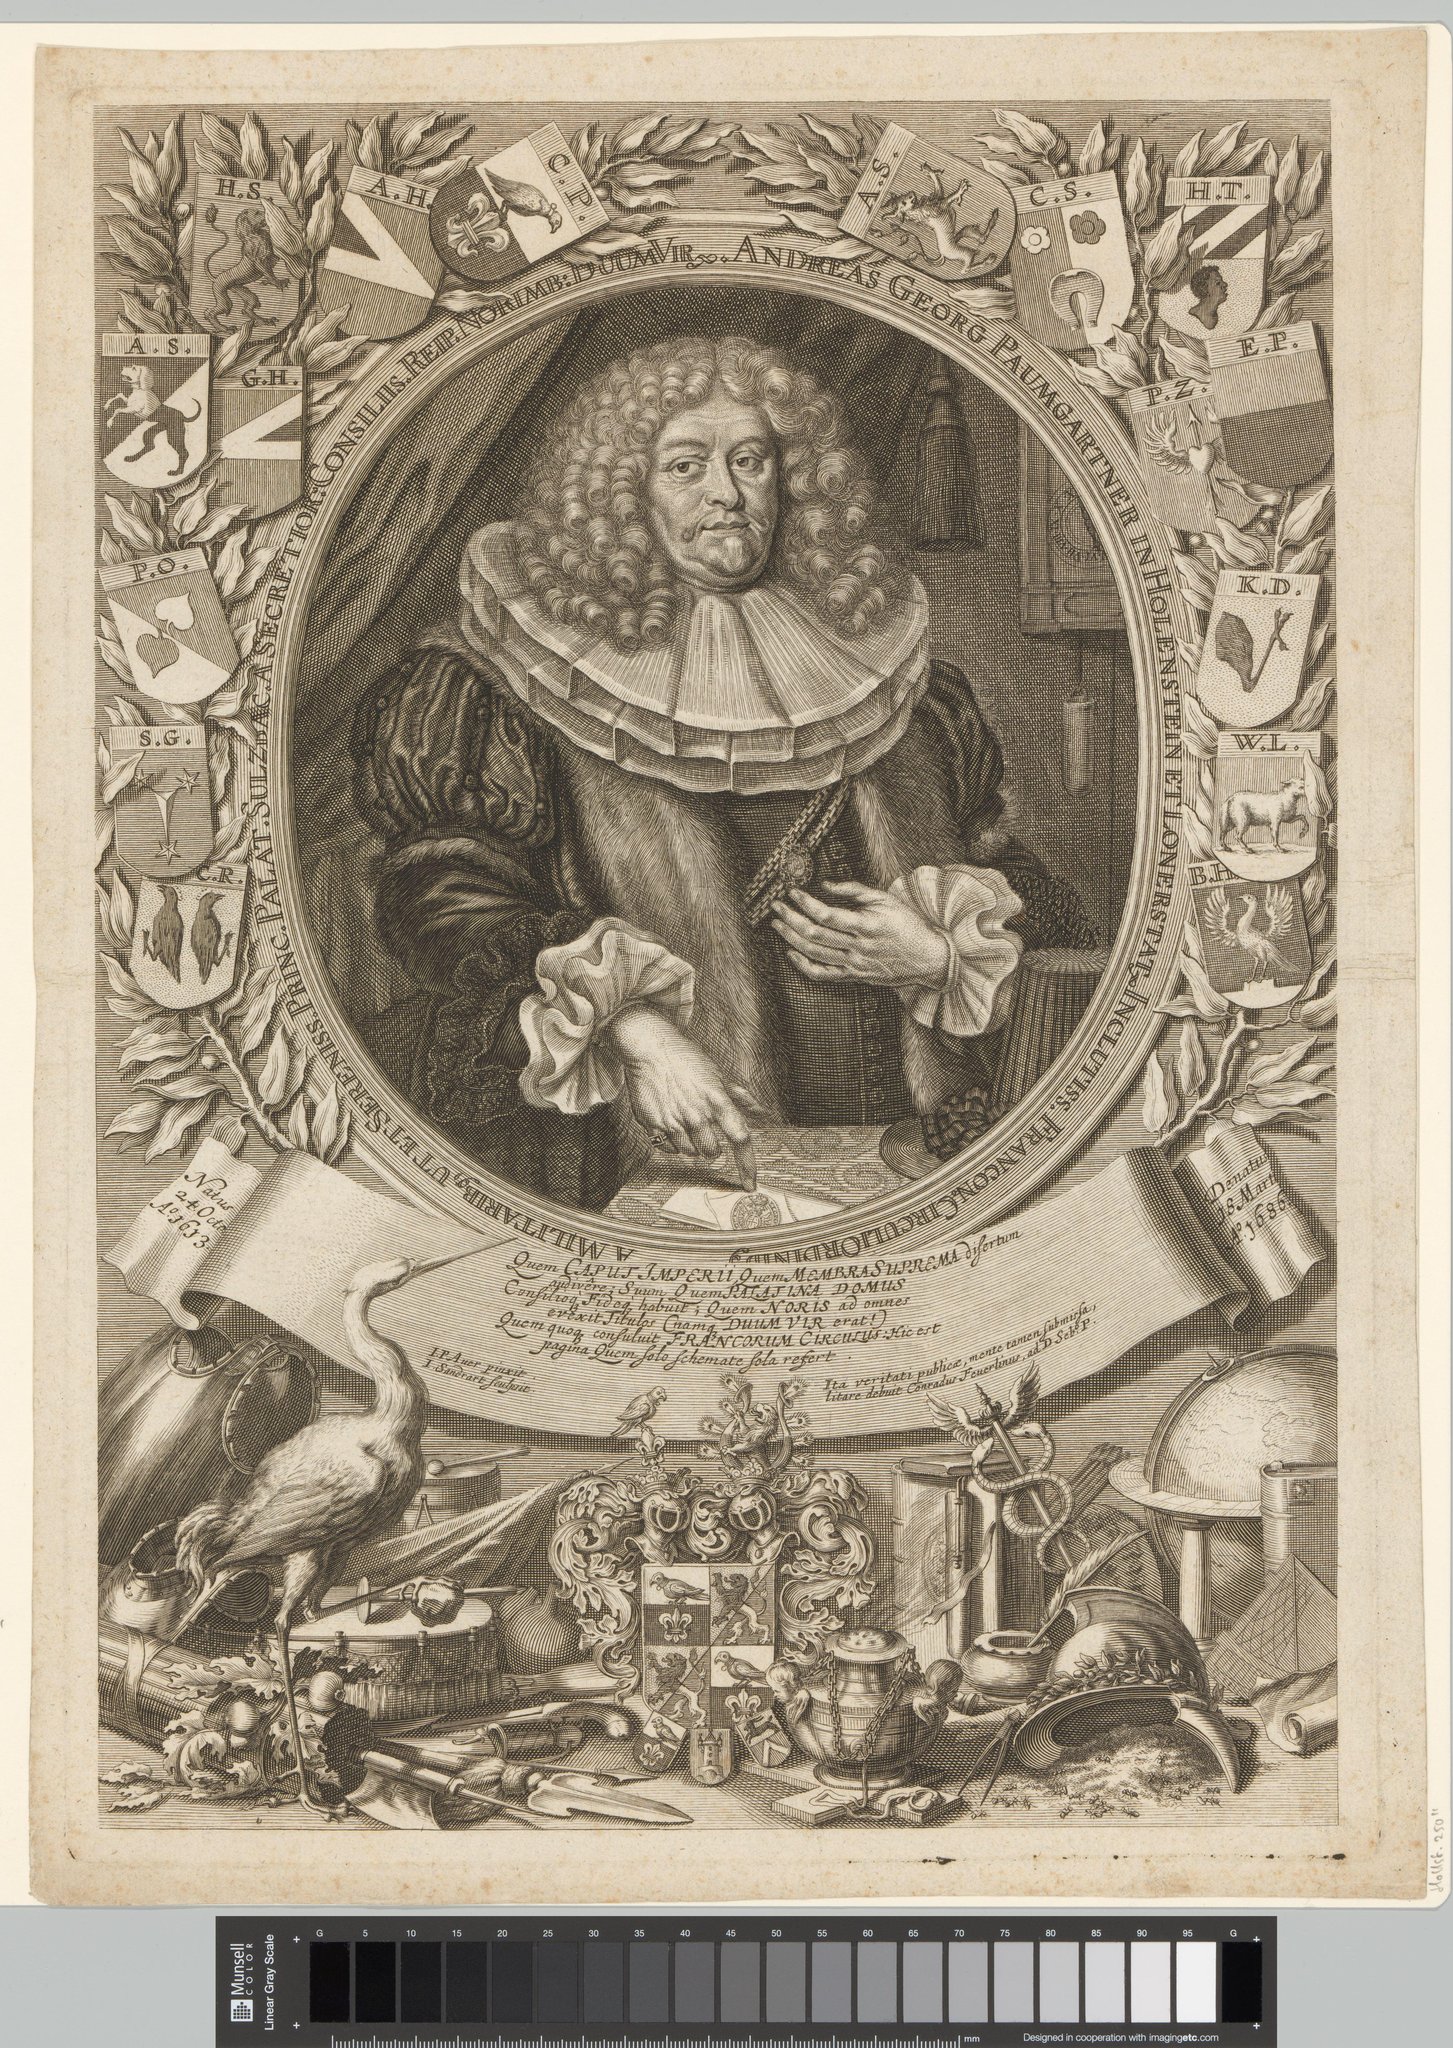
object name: print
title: Portret van Andreas Georg Paumgartner von Holenstein und Lonnerstadt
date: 1686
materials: paper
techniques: engraving, etching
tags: mayor, insects: ant, shore-birds and wading-birds: heron, historical persons, symbols, allegories of war; 'guerra' (ripa), the liberal arts represented otherwise, e.g. by emblems, symbols, armorial bearing, heraldry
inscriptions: collector's mark: Lugt 2228